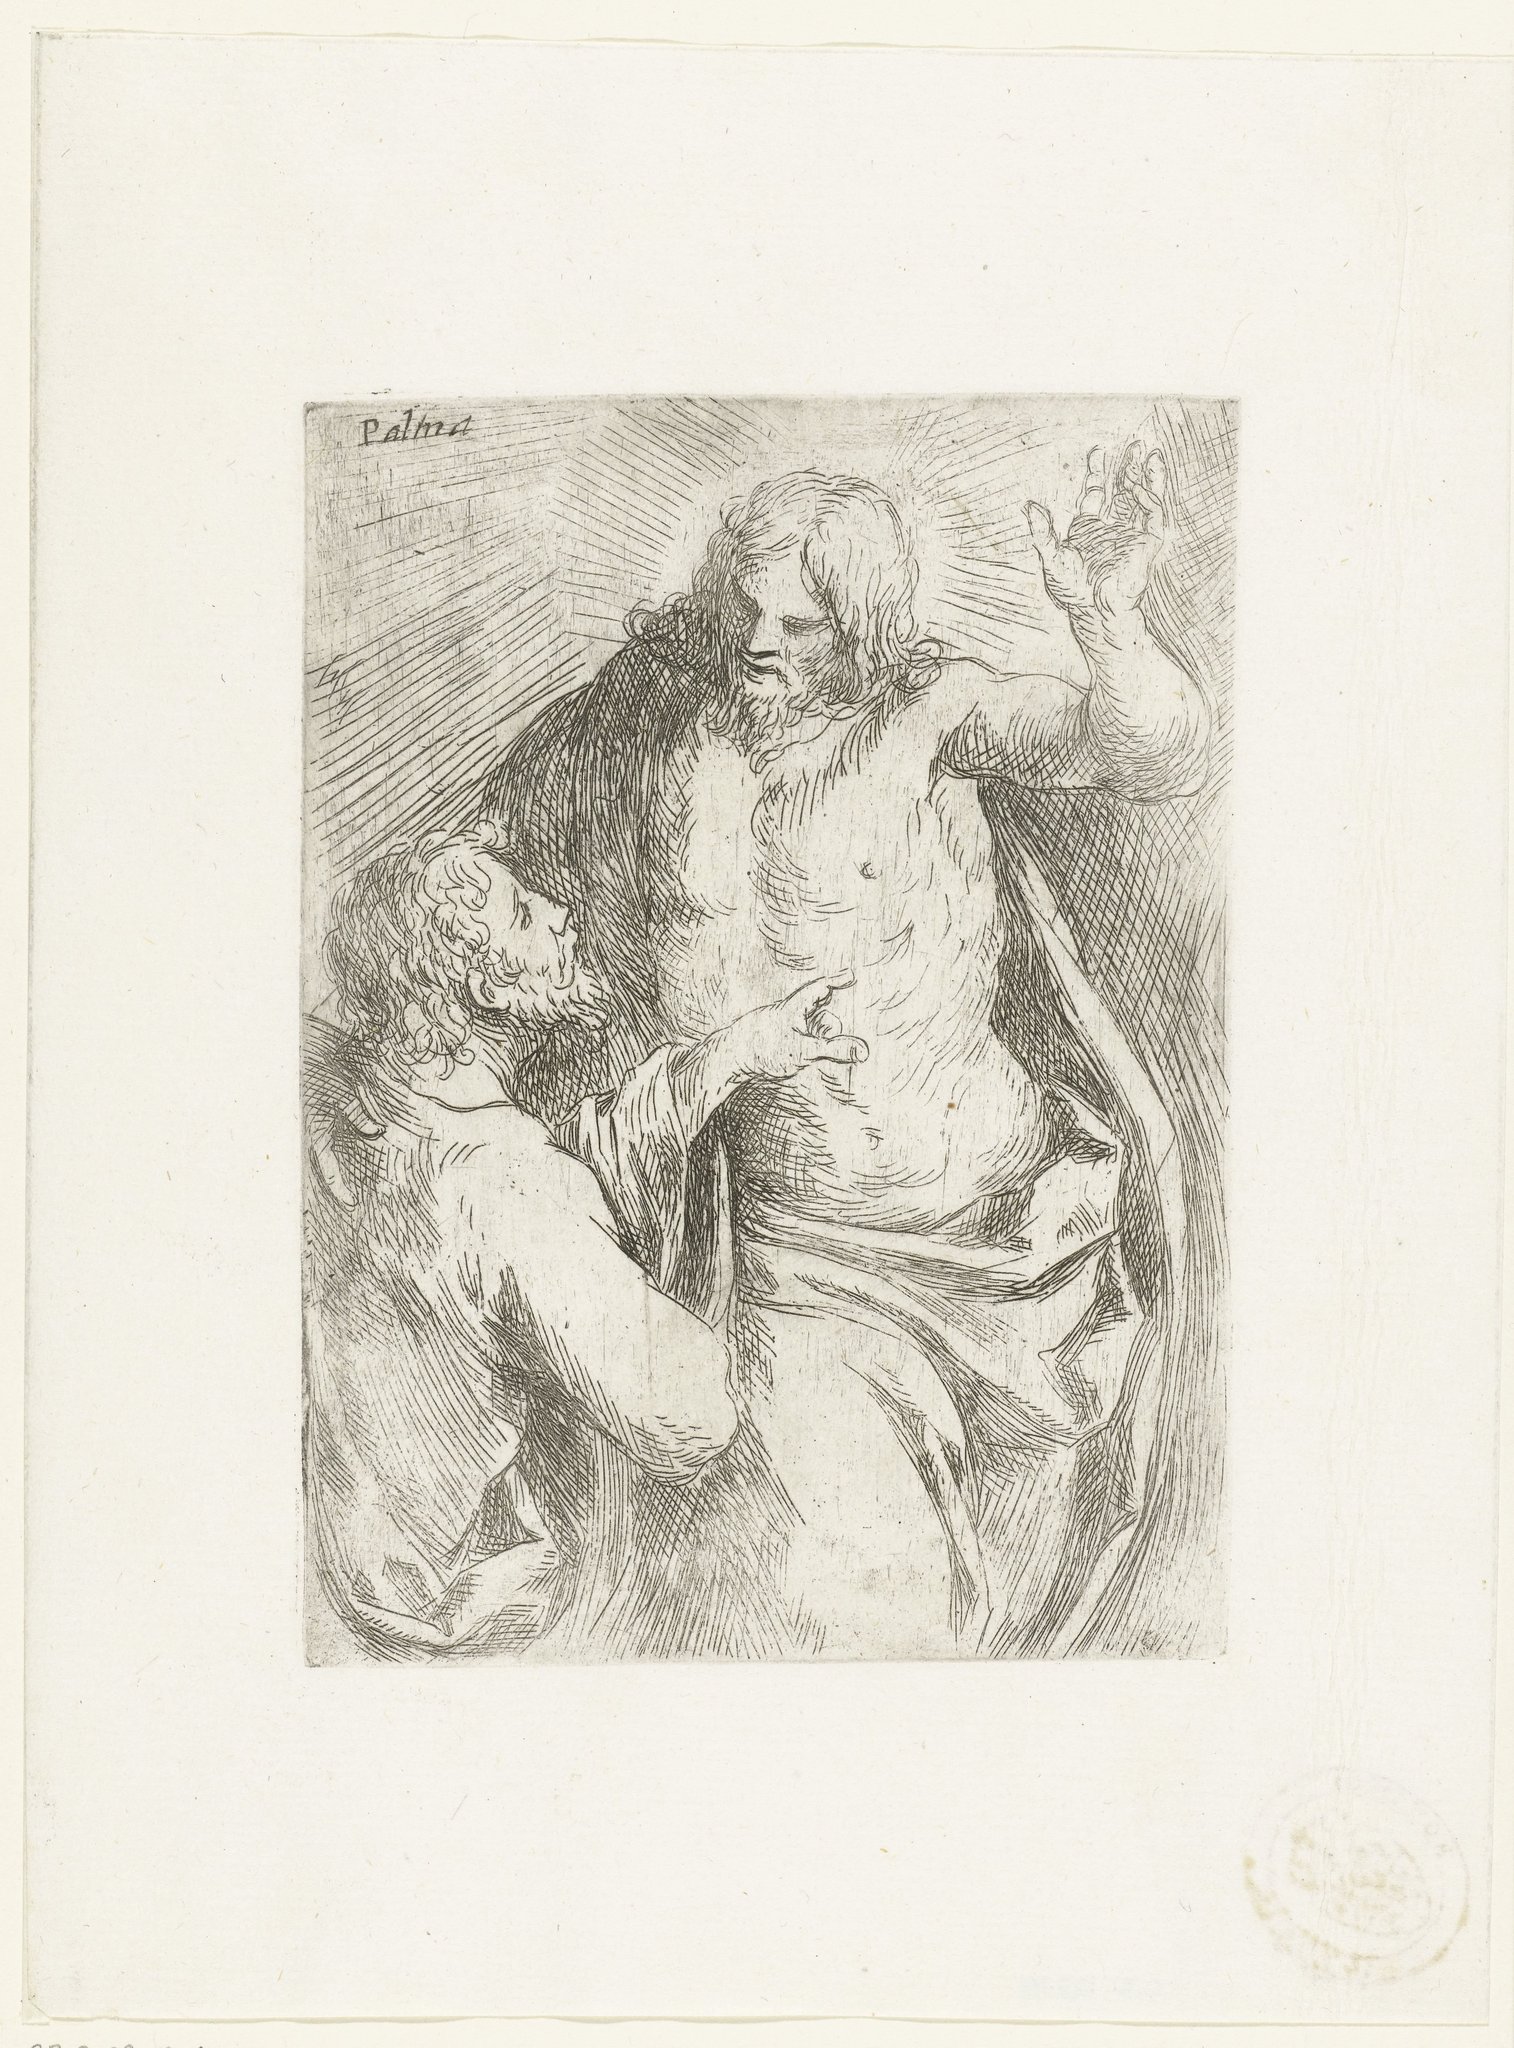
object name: print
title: De ongelovige Tomas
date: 1554-1611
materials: paper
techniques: etching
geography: italy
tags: thomas touching or stretching out his hands to touch the wound in christ's side, sometimes christ leading thomas' hand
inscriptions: collector's mark: Lugt 240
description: Een van de prenten uit De Excellentia et Nobilitate Delineationis Libri Duo, uitgegeven door Giacomo Franco in 1611.